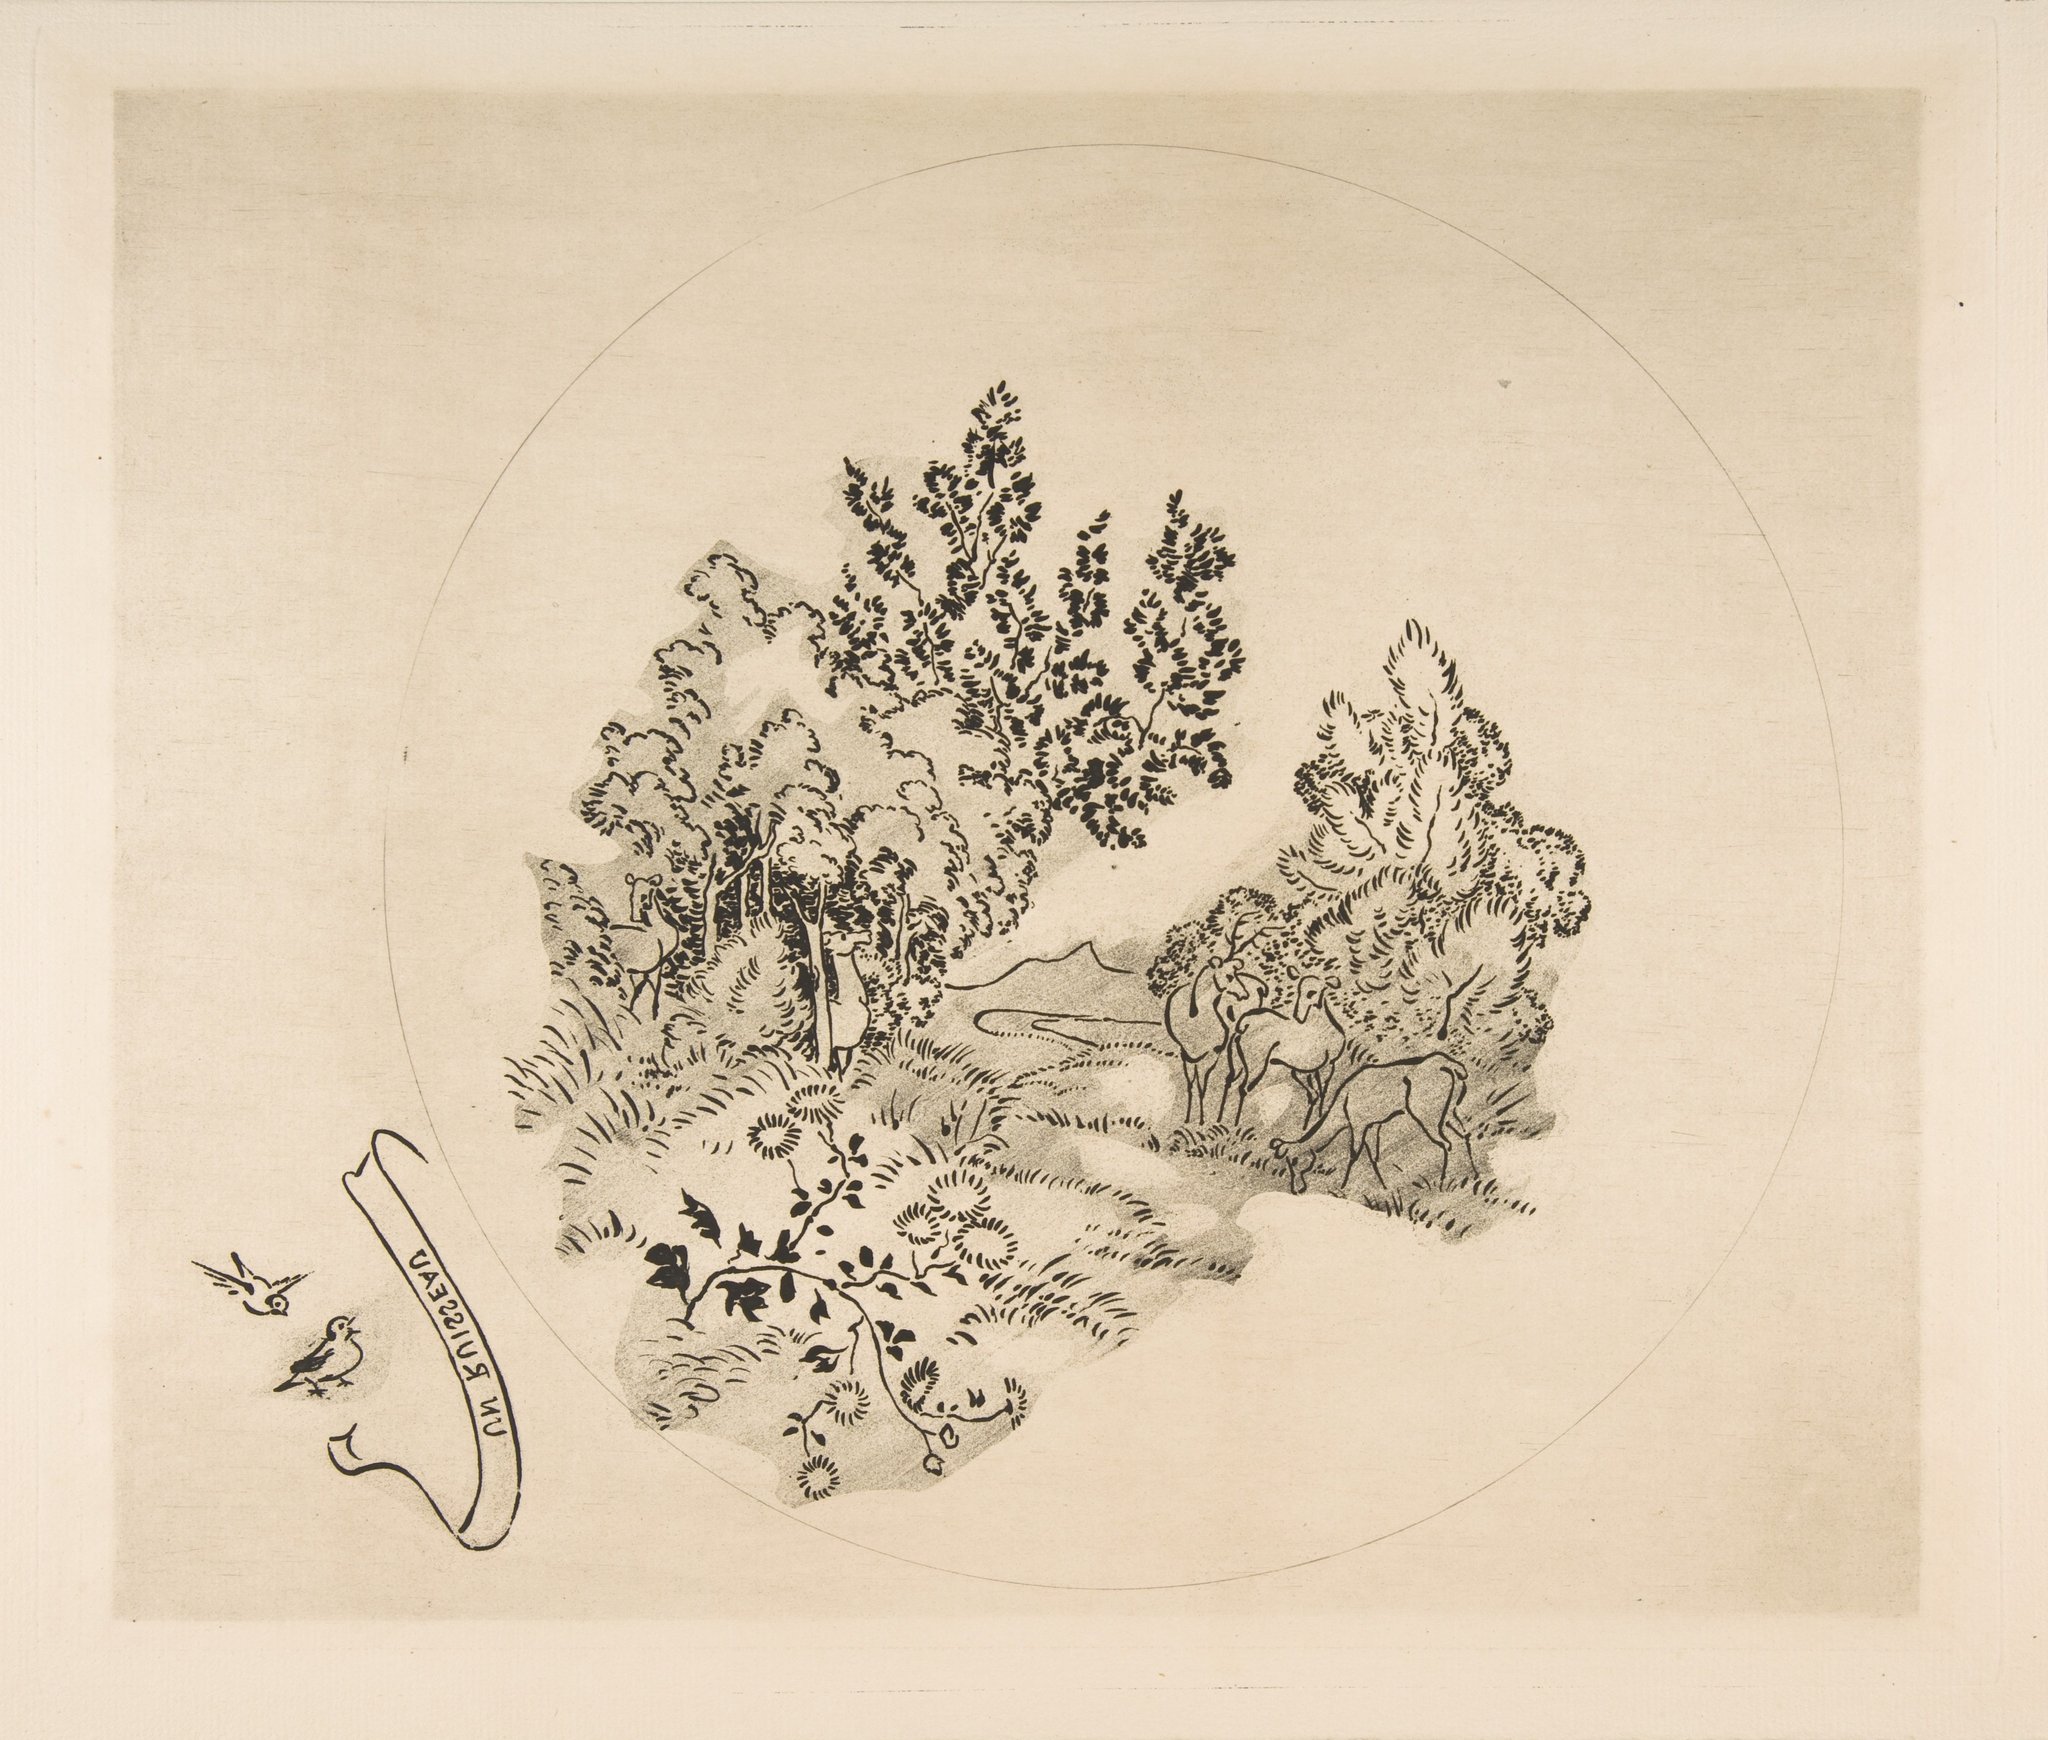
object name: print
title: Decoration for a Plate: A Stream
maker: félix bracquemond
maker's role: artist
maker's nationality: french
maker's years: 1833-1914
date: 1870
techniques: aquatint, etching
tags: trees